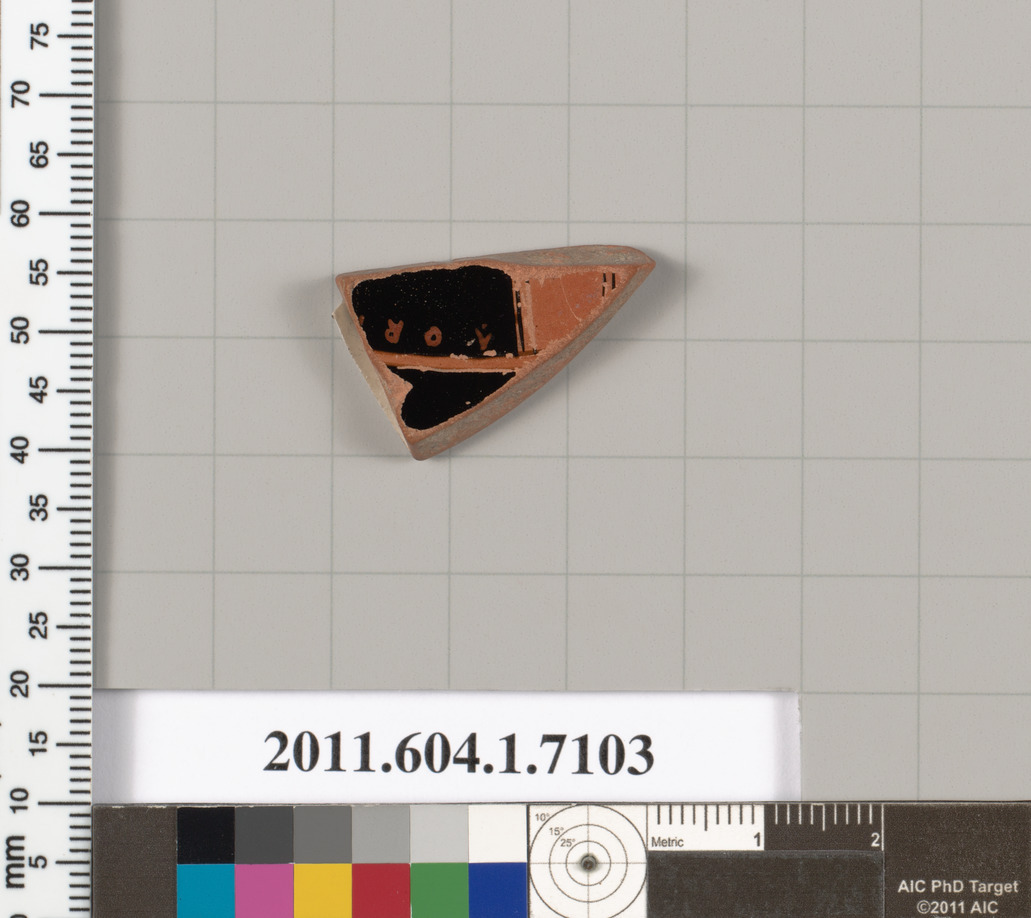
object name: kylix fragment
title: Terracotta fragment of a kylix (drinking cup)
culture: greek, attic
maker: douris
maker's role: artist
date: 500-480 BCE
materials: terracotta